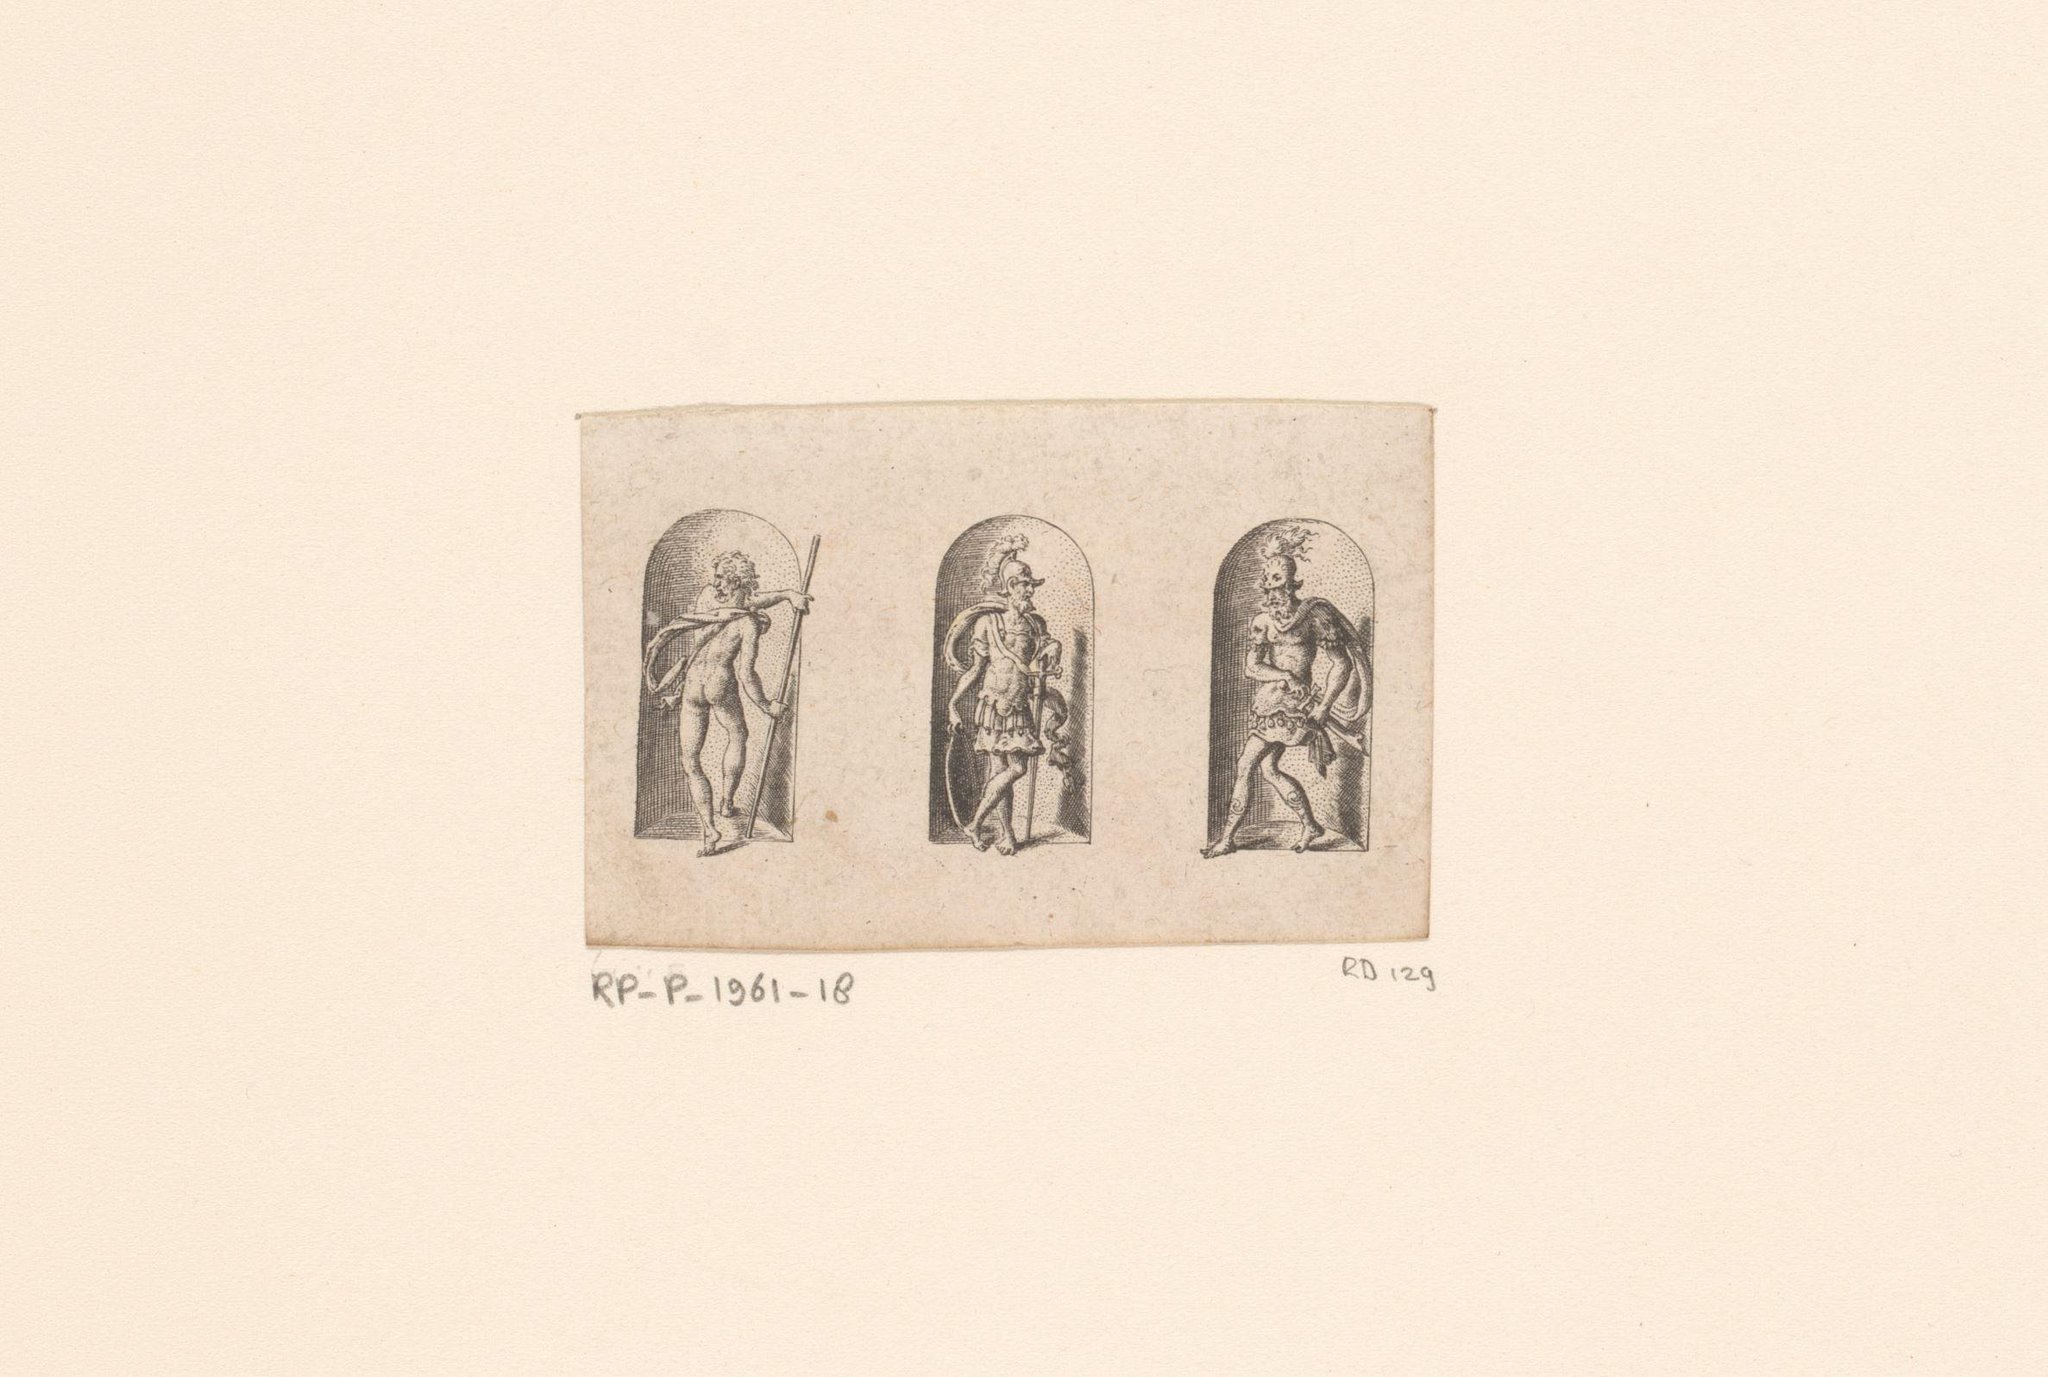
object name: print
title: Drie nissen met figuren waaronder Saturnus en Mars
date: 1578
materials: paper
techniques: engraving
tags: (story of) saturn (cronus), (story of) mars (ares)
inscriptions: collector's mark: Lugt 2228, collector's mark: Lugt 2760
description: Maakt deel uit van een zevendelige serie (inclusief titelprent) met op elke prent drie klassieke goden in nissen. Enkel de titelprent vormt een uitzondering. Hier zijn twee in plaats van drie nissen weergegeven, waar de figuren geen goden voorstellen. Waarschijnlijk vervaardigde Delaune deze prenten tijdens zijn verblijf in Duitsland (Pollet, p. 693).